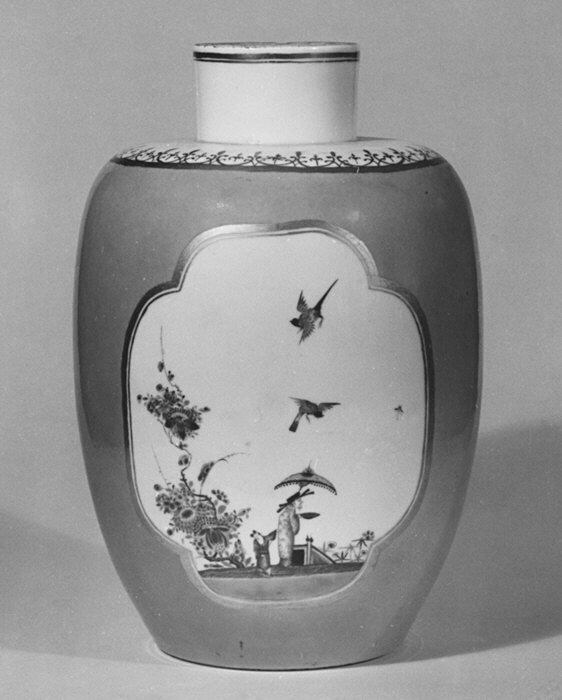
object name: vase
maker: meissen manufactory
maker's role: manufactory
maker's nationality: german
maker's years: 1710-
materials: hard paste porcelain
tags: birds,chinoiserie,flowers